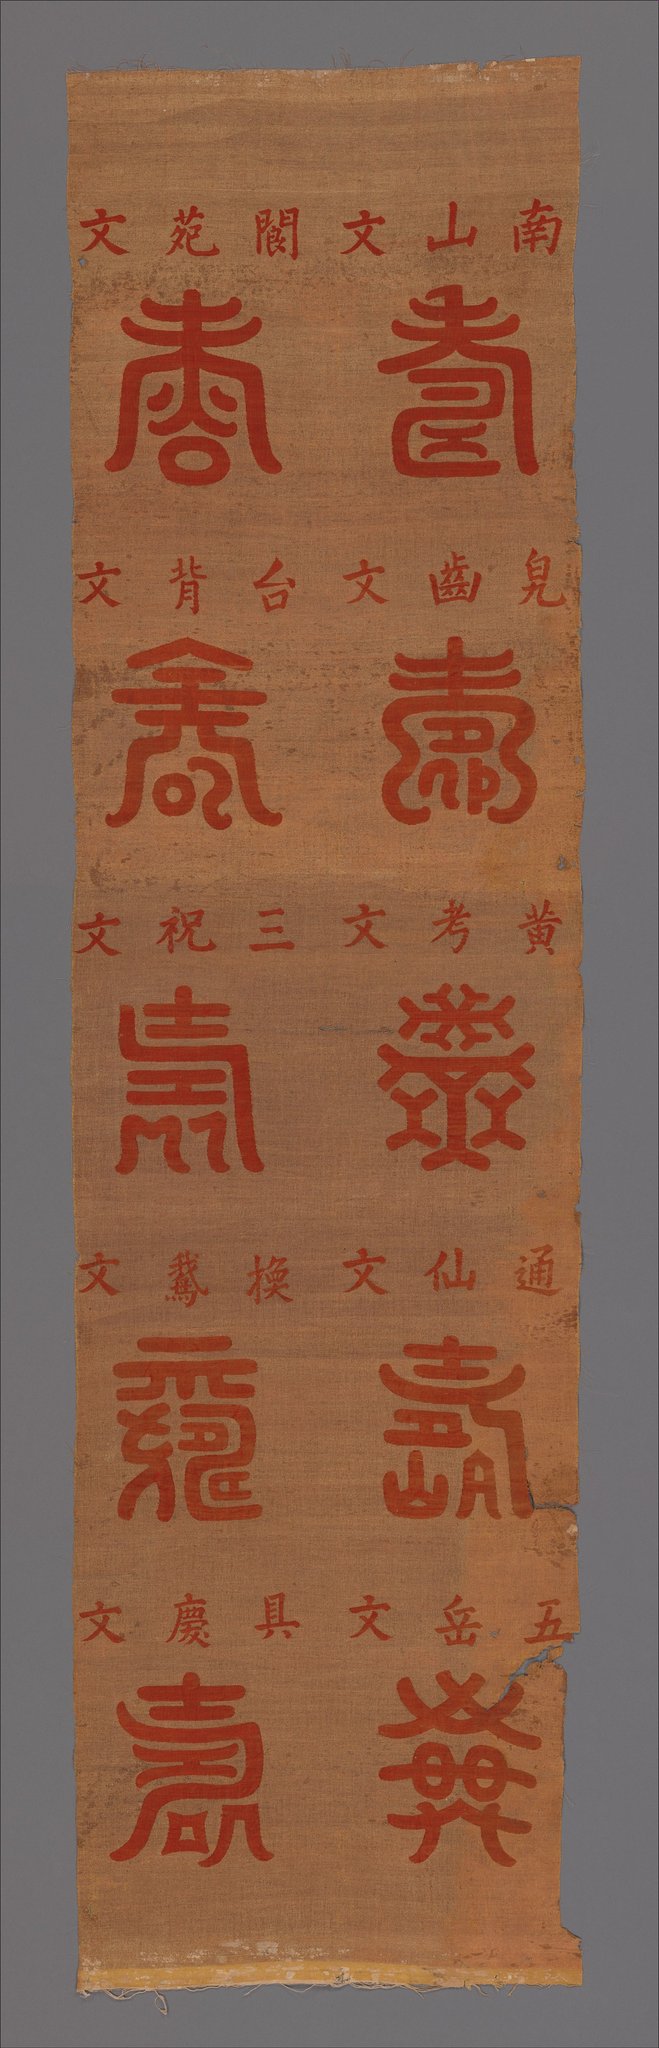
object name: piece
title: Panel with Longevity (Shou) Characters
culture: chinese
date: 1801-1900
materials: metal thread, silk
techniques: tapestry